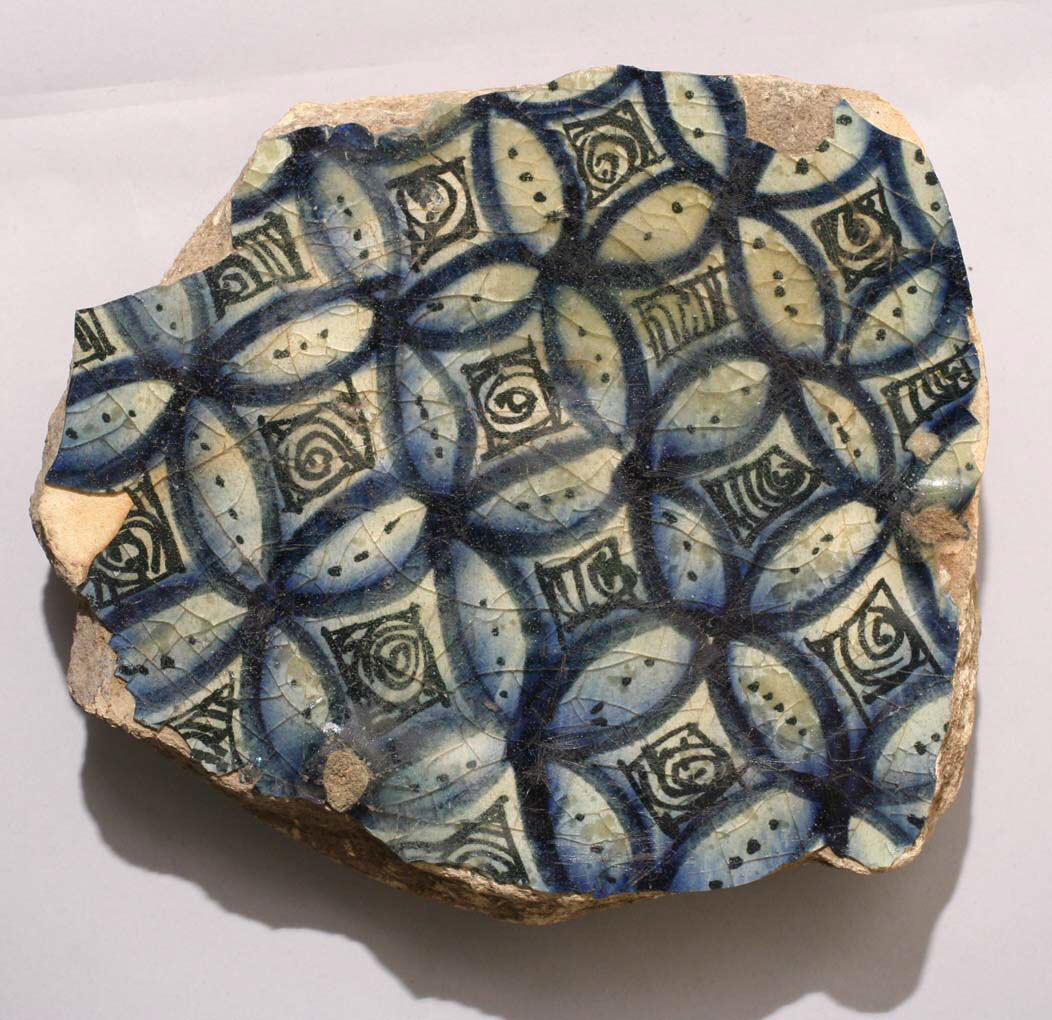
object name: fragment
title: Fragment of a Bowl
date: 1301-1500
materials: glaze, stonepaste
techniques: underglaze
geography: egypt